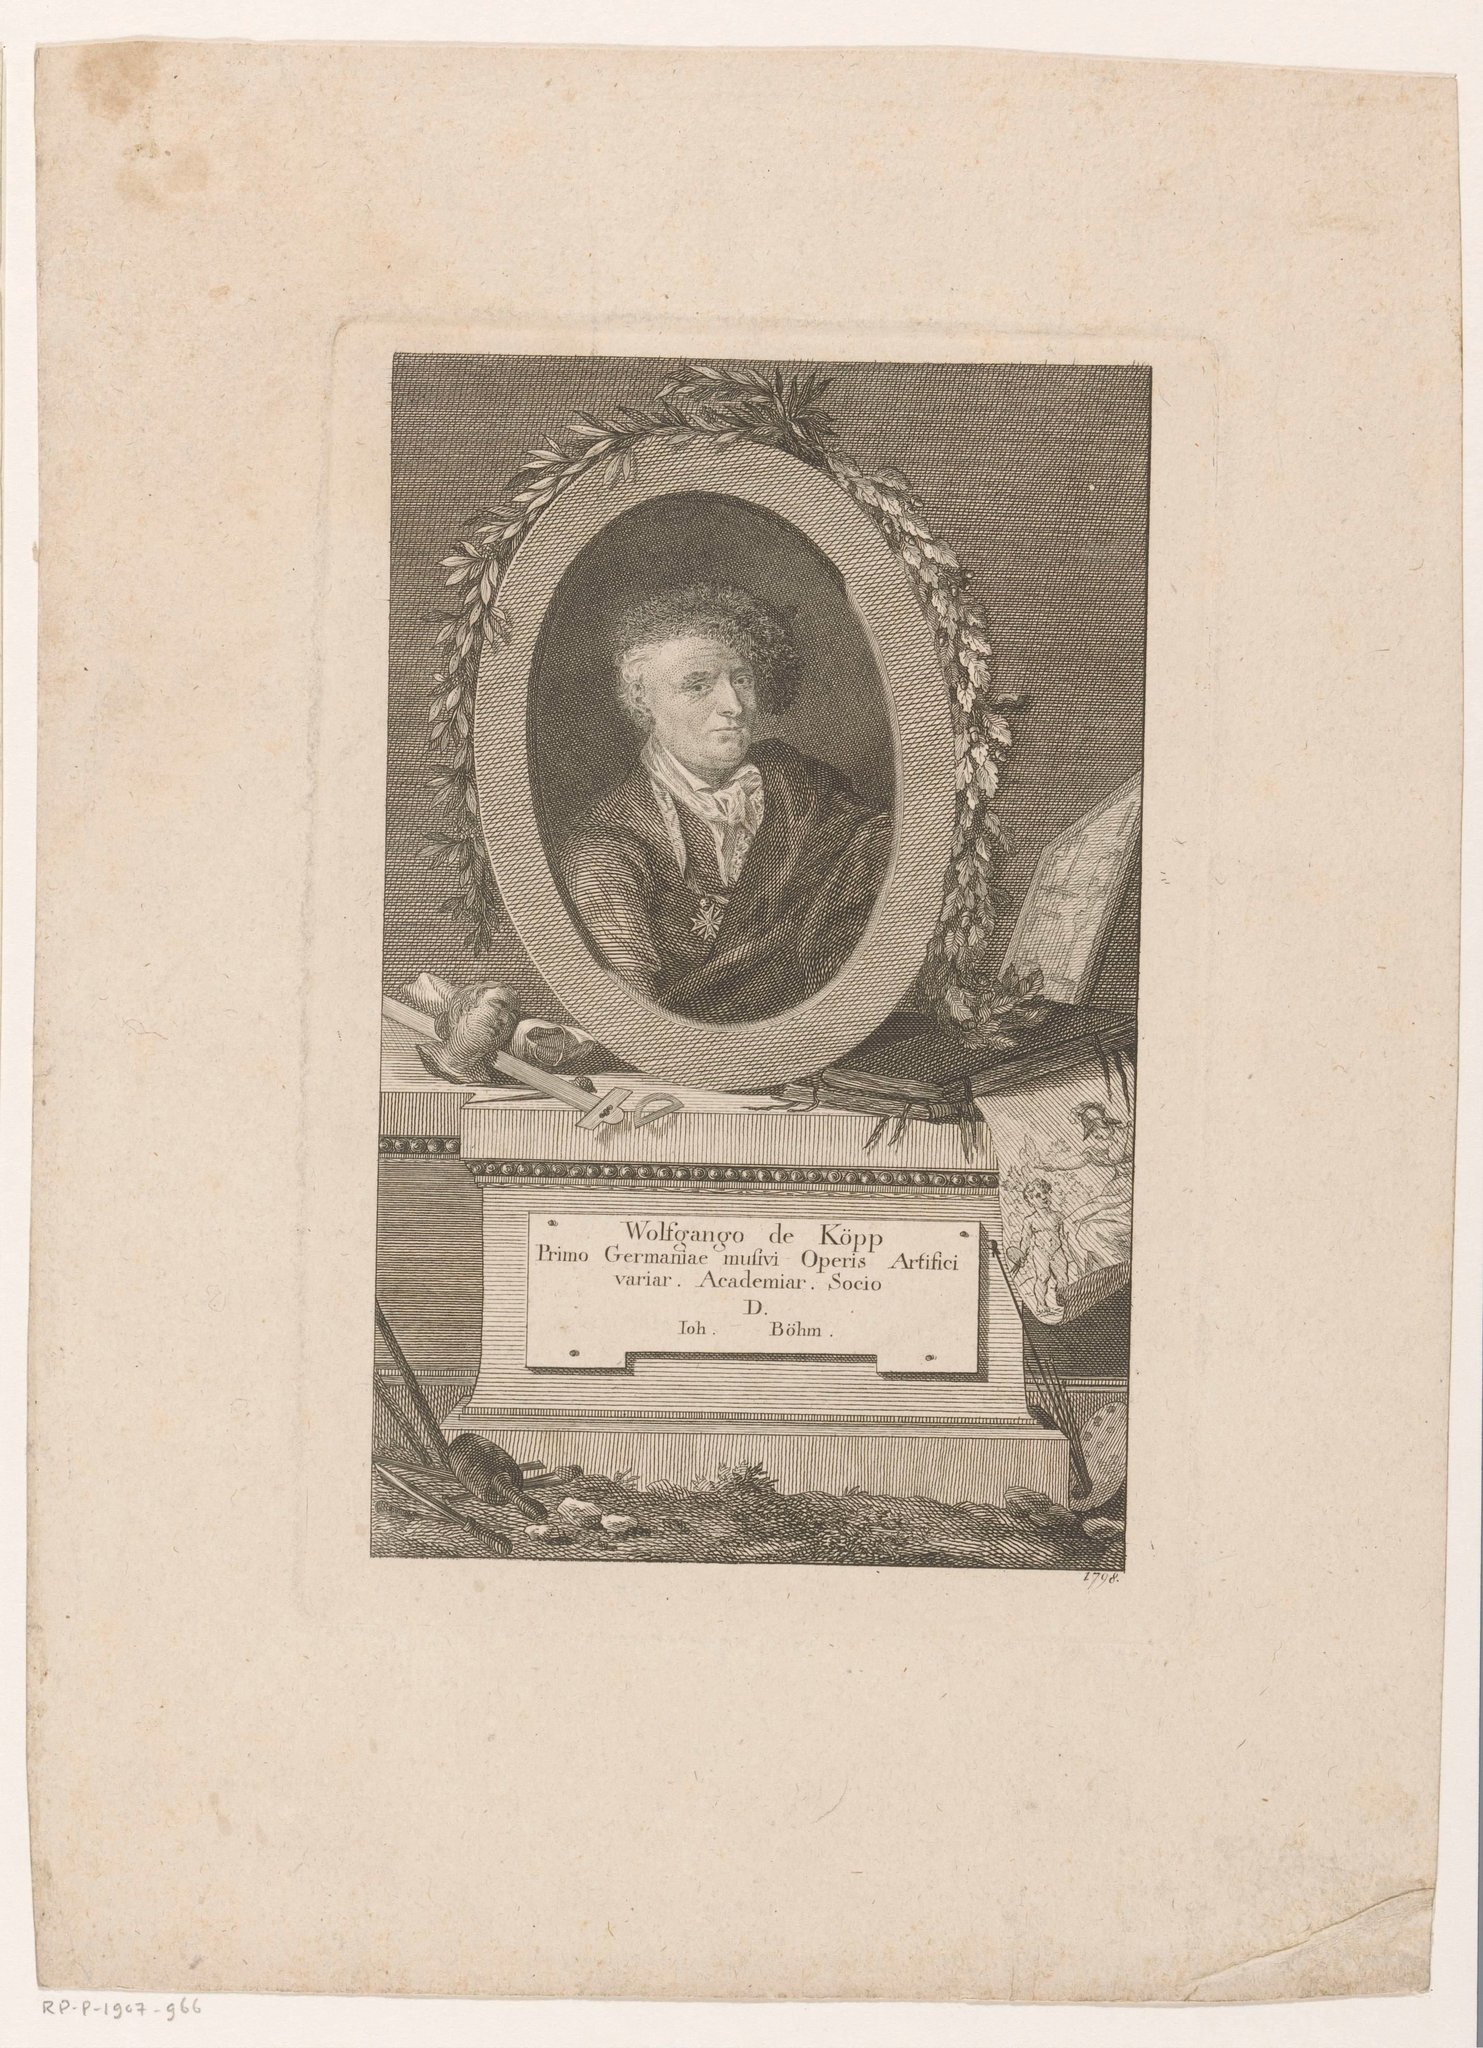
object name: print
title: Portret van Wolfgang Koepp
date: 1798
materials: paper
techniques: engraving, etching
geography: leipzig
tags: vienna, painter, wolfgang koepp, drawing, historical persons, tools, implements of painter, portrait, self-portrait of artist, tools, implements of draughtsman, tools, implements of sculptor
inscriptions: collector's mark: Lugt 2228